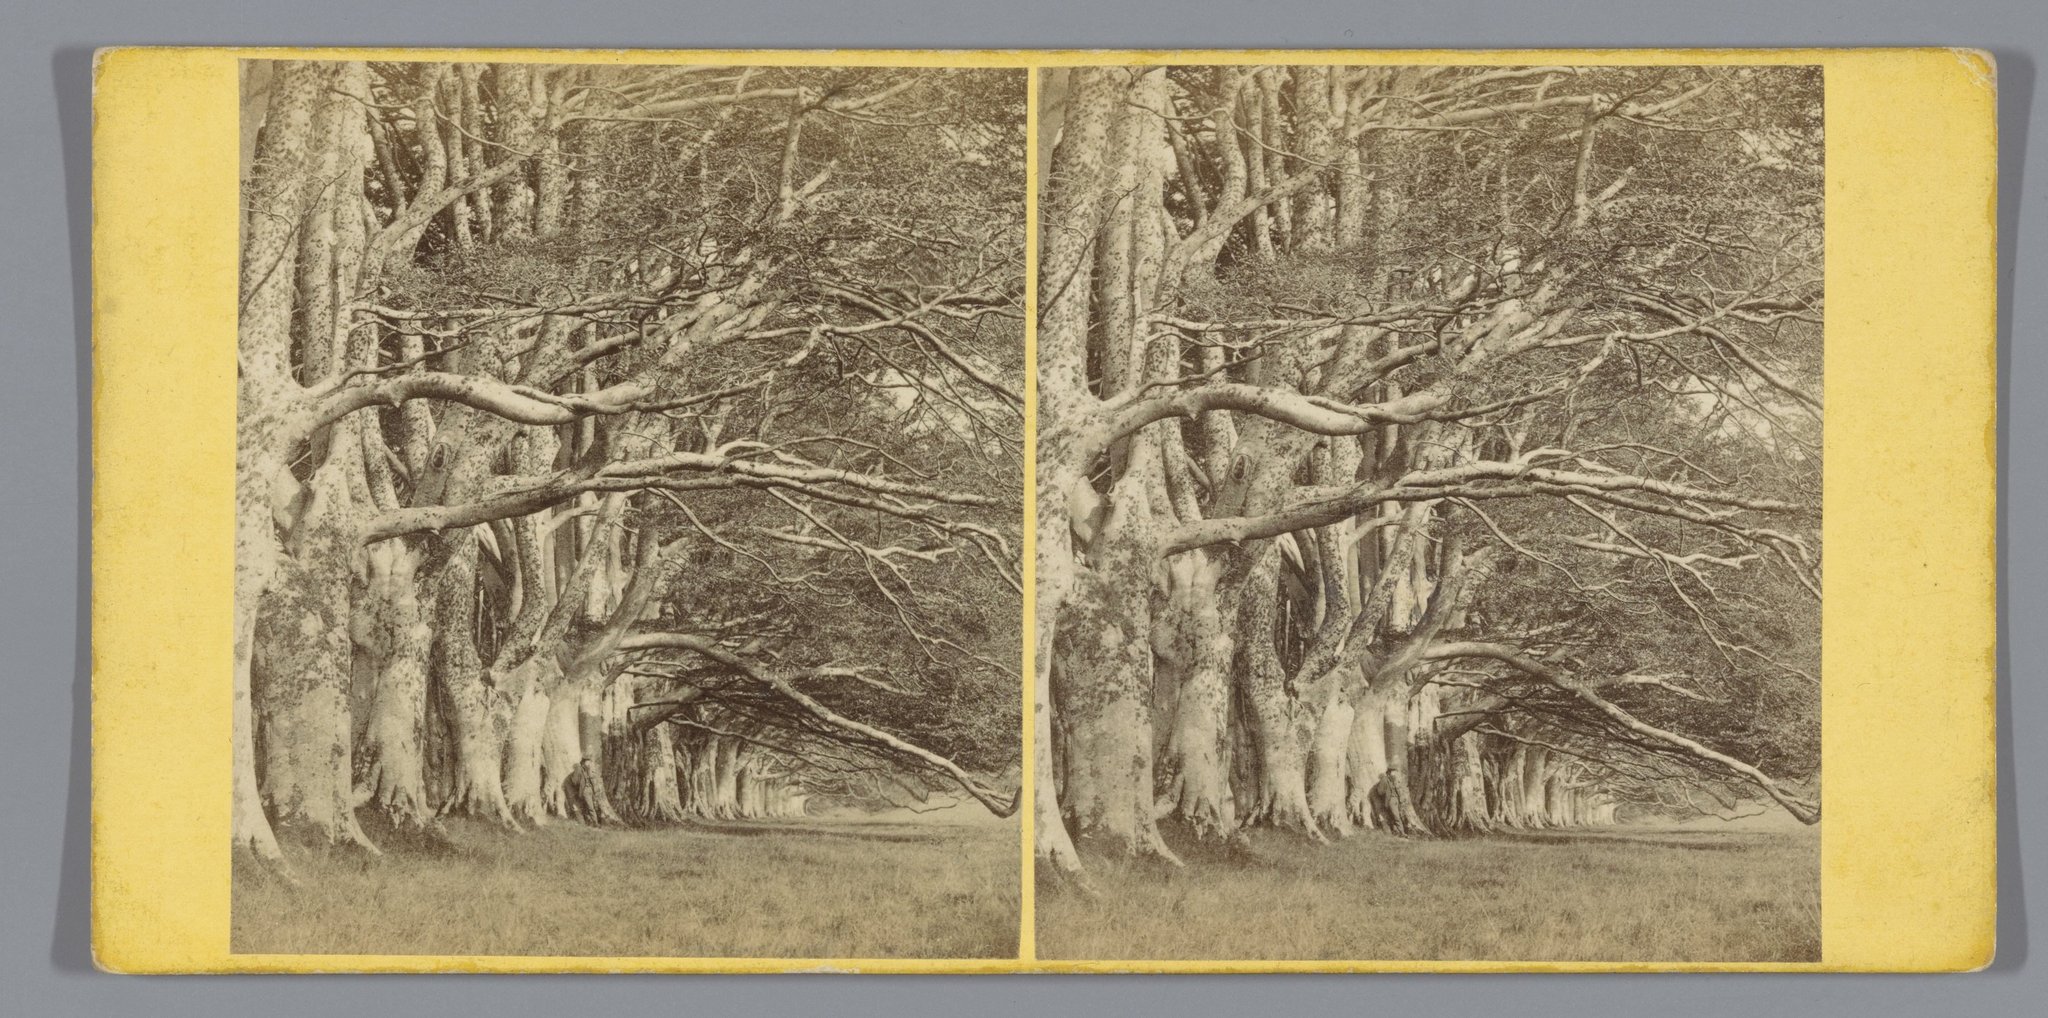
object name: stereograph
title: The Dhu Loch Avenue, Inverary.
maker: george washington wilson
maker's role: publisher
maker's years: 1823-1893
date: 1850-1880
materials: cardboard, photographic support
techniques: albumen print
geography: inveraray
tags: forest path or lane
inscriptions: number: ‘No. 678 A.’